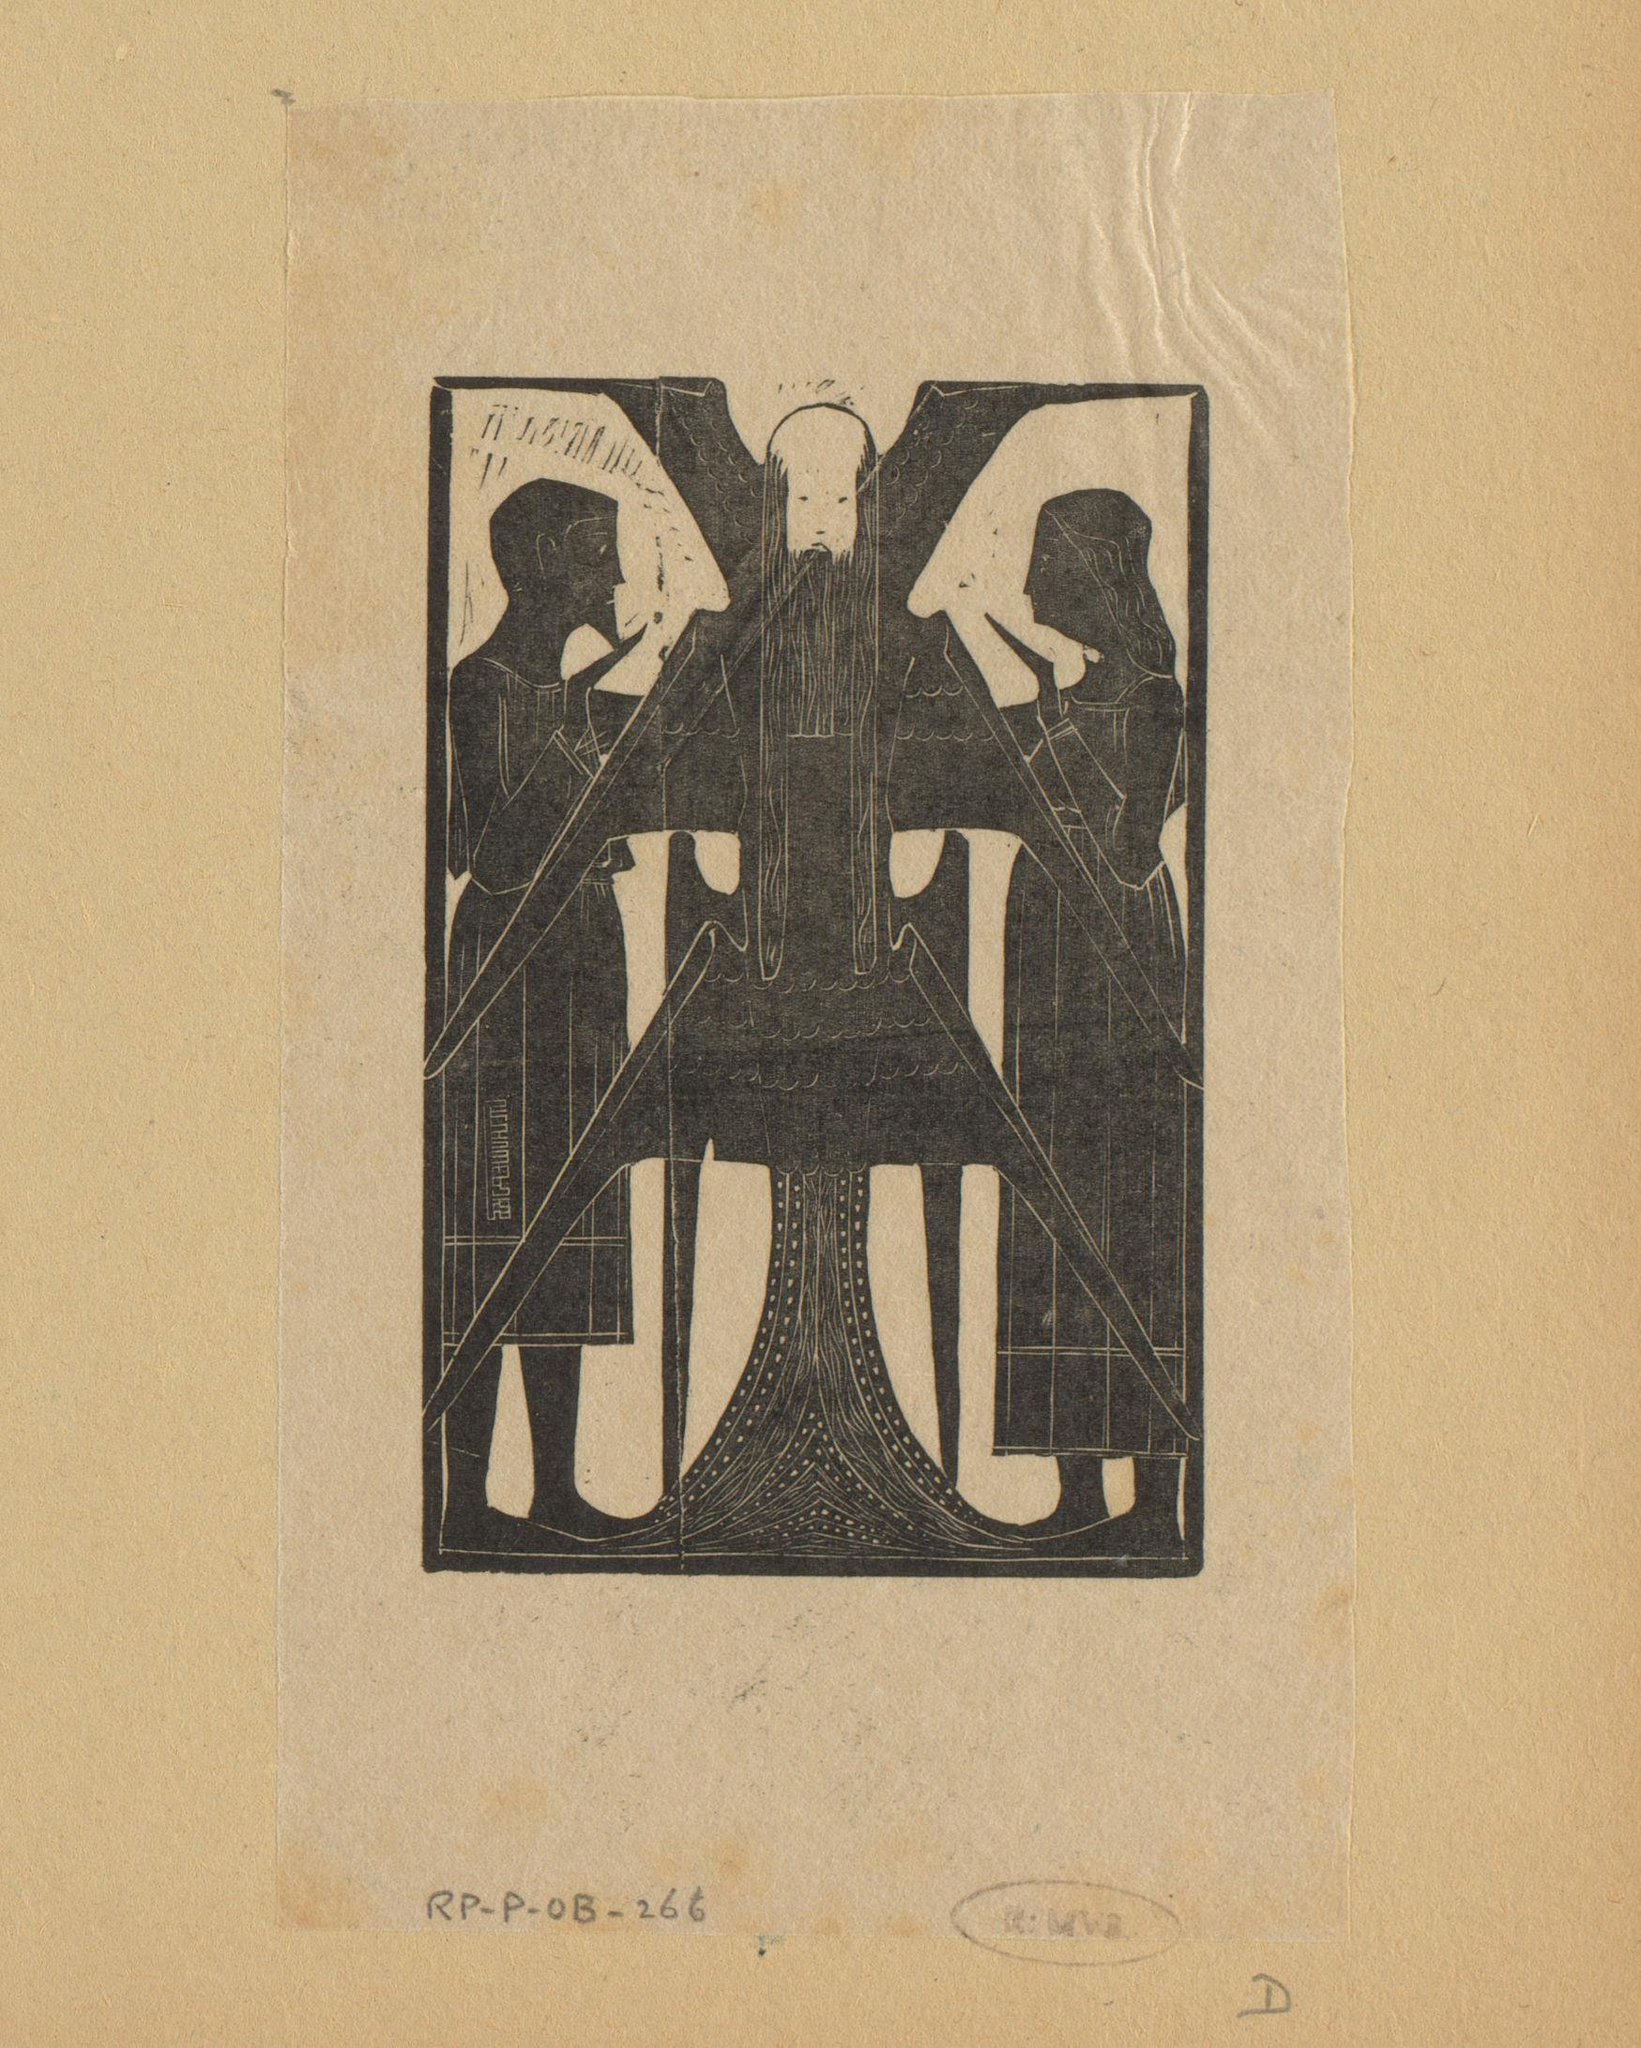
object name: album leaf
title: In een veraf gelegen wereld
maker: mathieu lauweriks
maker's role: designer, draughtsman, print maker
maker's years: 1864-1932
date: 1895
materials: paper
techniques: woodcut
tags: fabulous beings with wings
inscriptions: collector's mark: Lugt 2228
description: In het midden een figuur met lang haar en een baard en drie paar gespreide vleugels. Links staat een vrouw; rechts een man met een sik. Beiden houden hun hand gestrekt in de richting van de gevleugelde figuur. Deze prent maakt deel uit van een album.